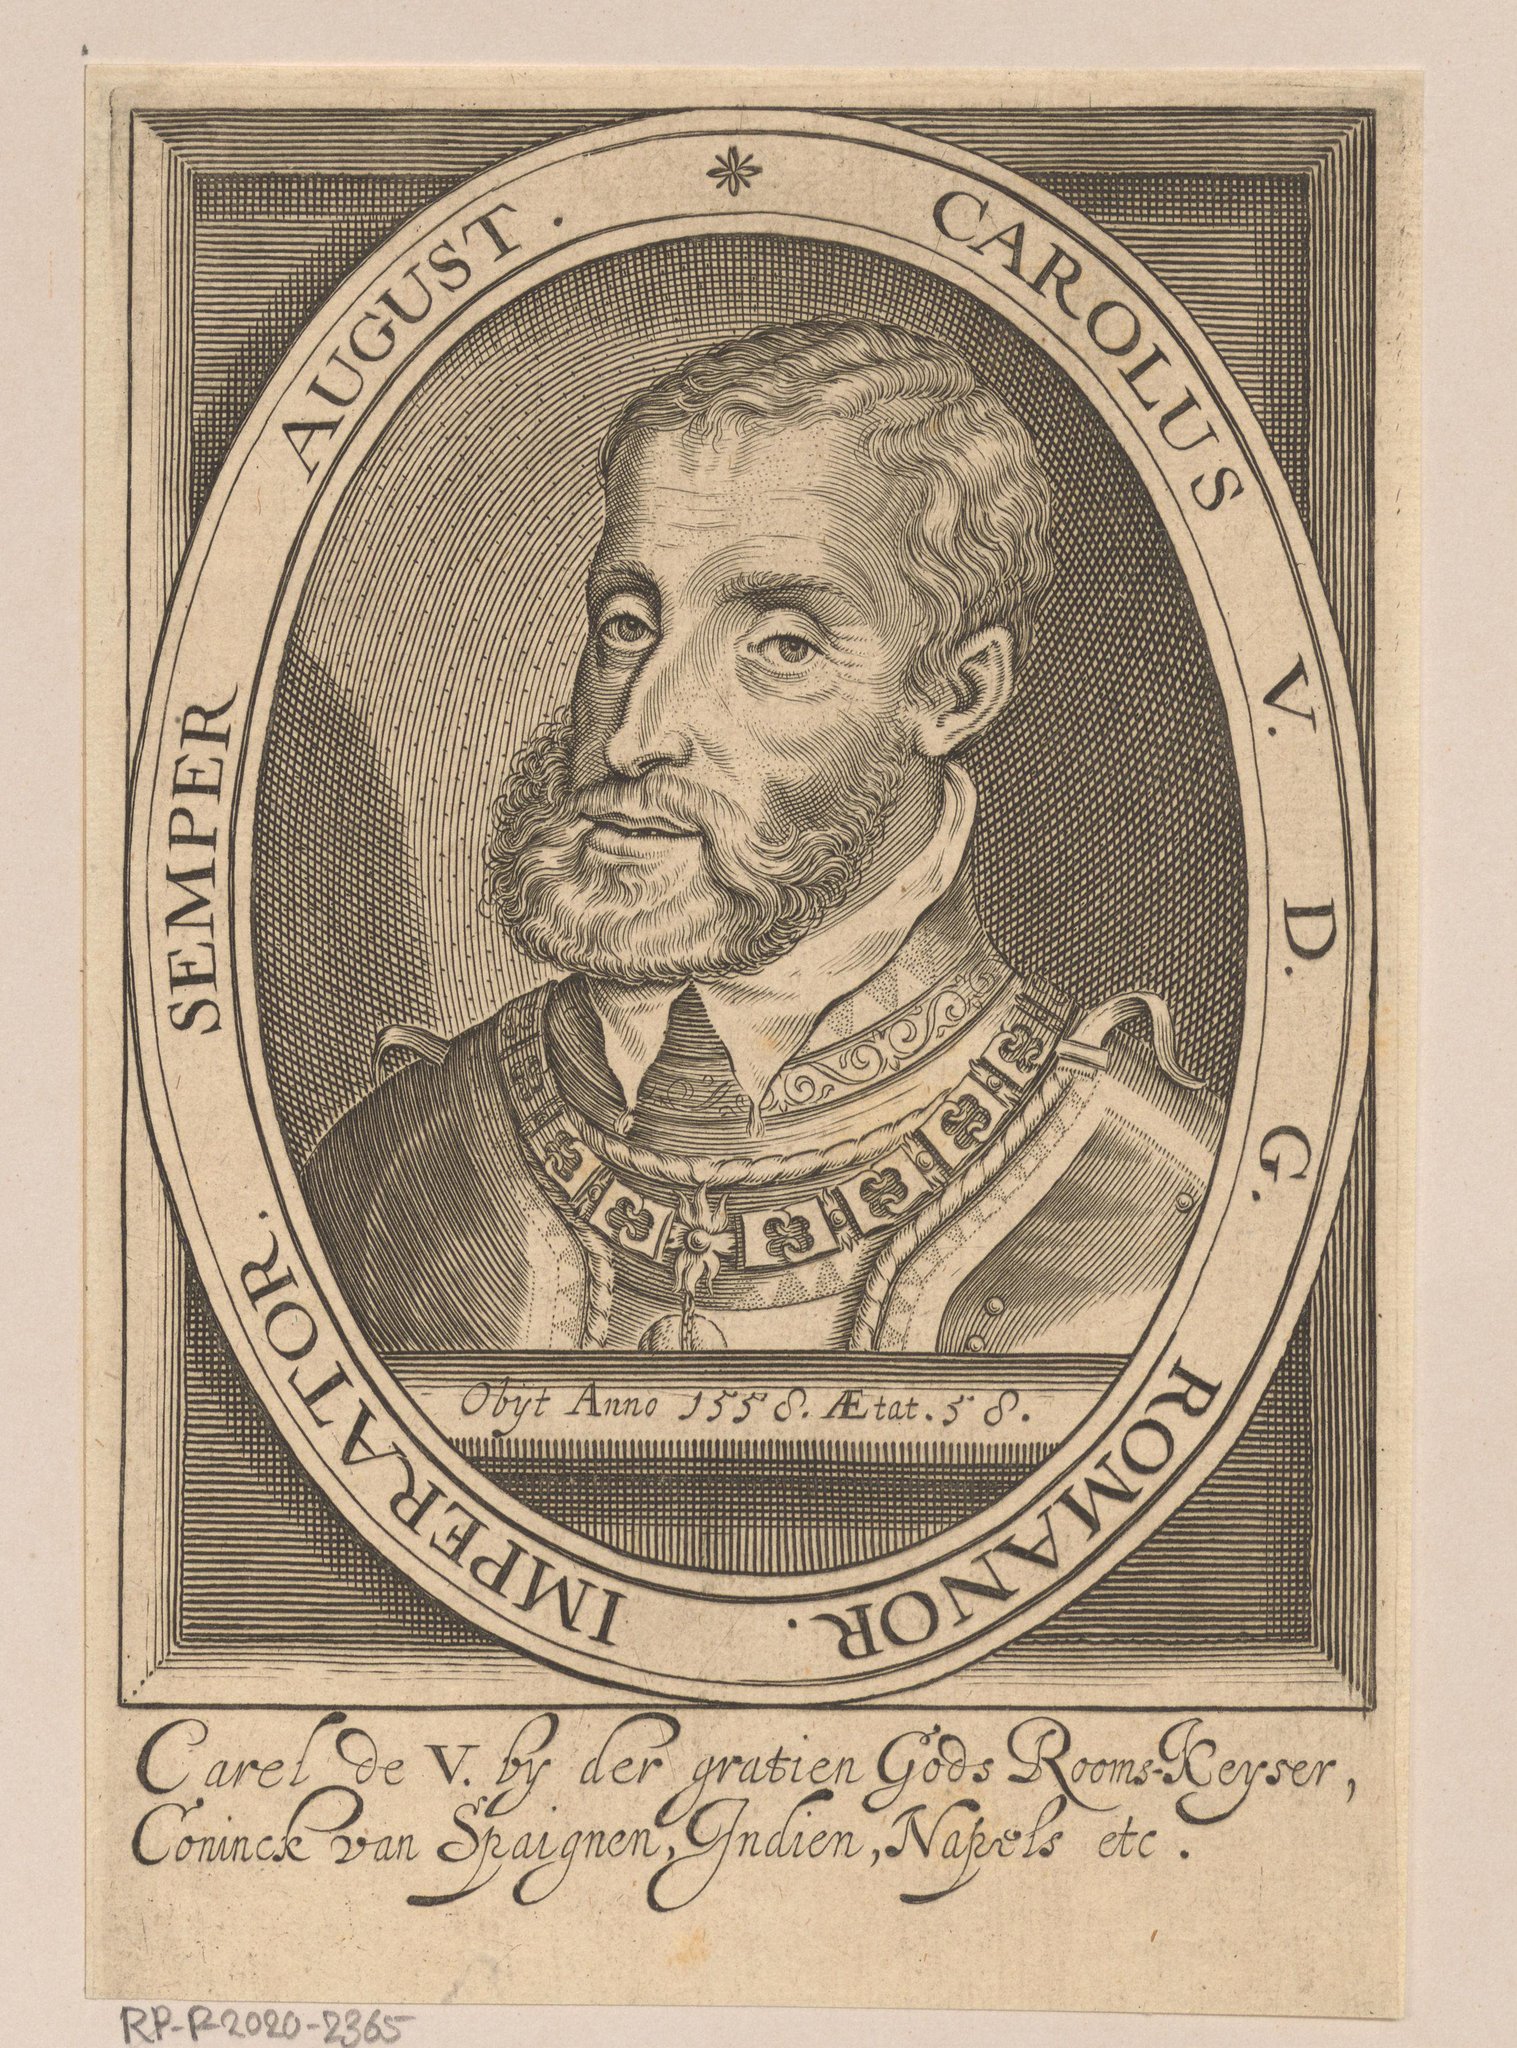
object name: print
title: Portret van keizer Karel V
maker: Anonymous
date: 1596-1699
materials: paper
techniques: engraving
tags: ghent, charles v (holy roman emperor and king of spain), historical persons, knighthood order of the golden fleece, king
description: Prent mogelijk gebruikt in meerdere edities en vertalingen van Emanuel van Meterens 'Nederlantsche historien'.